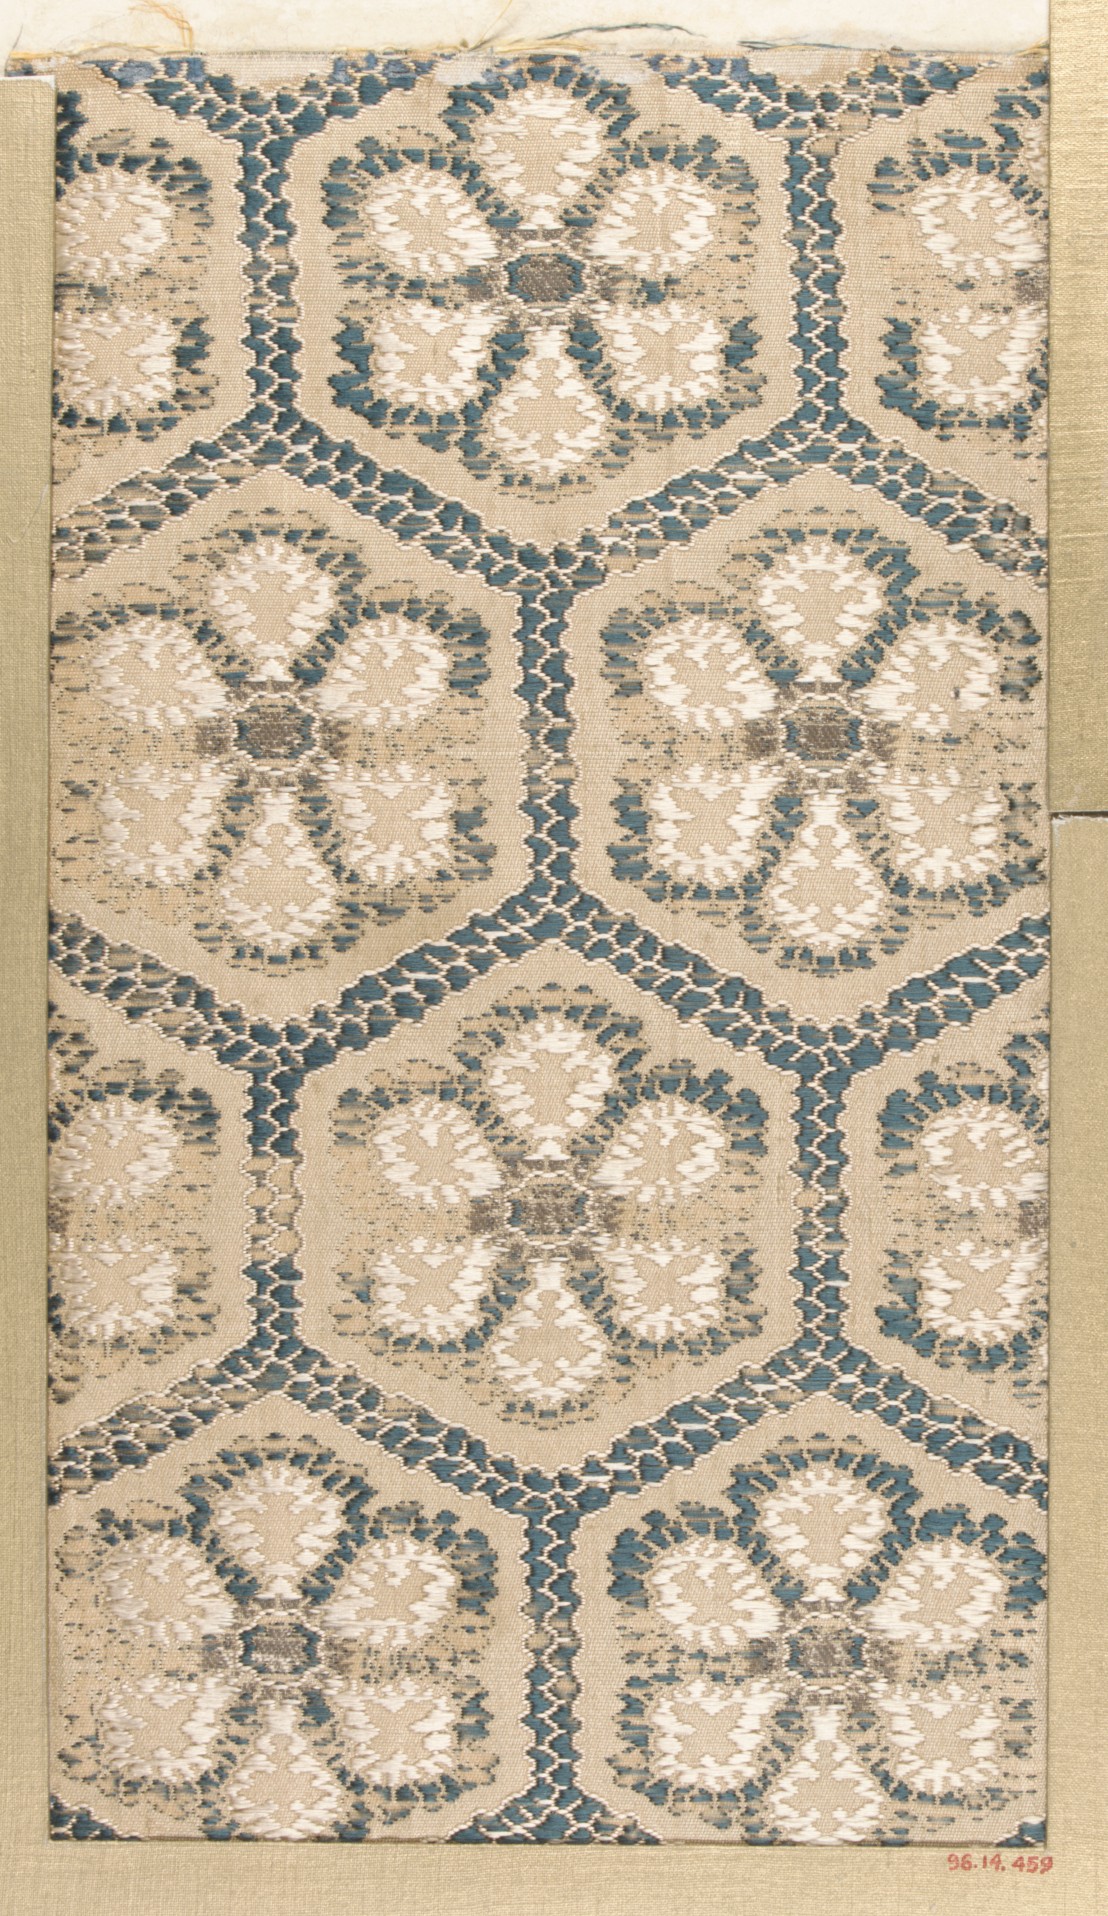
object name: piece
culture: japanese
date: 1701-1900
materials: silk